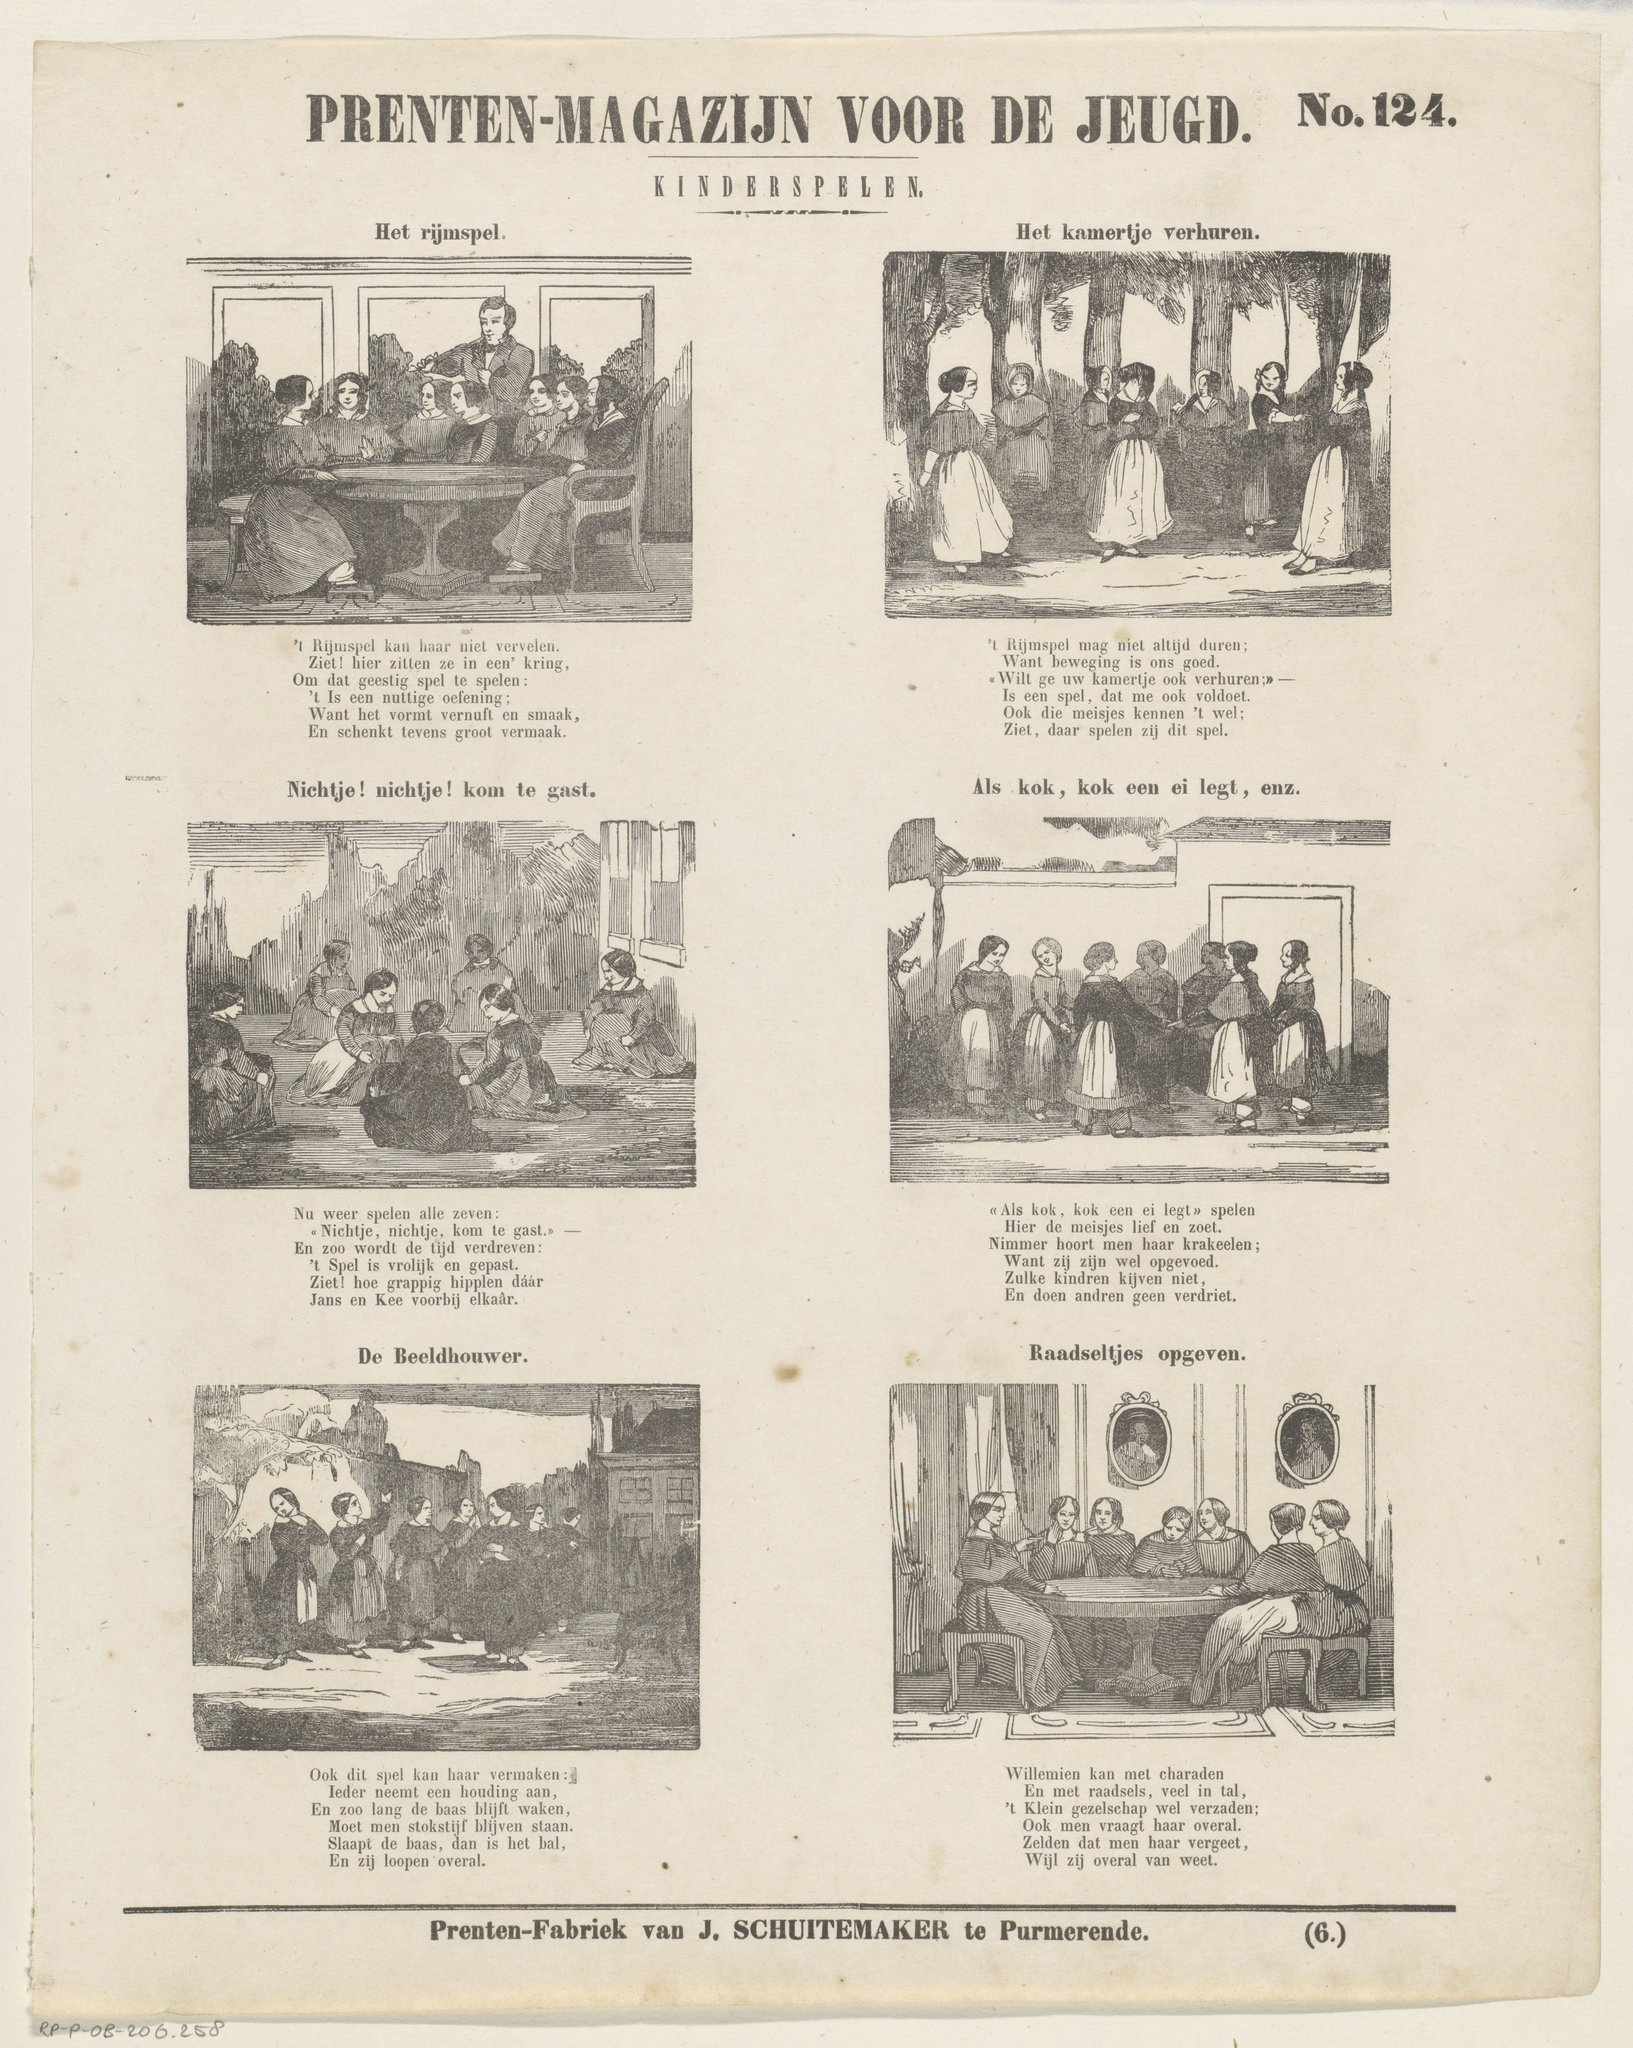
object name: print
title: Prenten-magazijn voor de jeugd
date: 1850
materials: paper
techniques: letterpress printing, engraving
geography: netherlands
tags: children's games and plays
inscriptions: collector's mark: Lugt 2760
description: Na voltooiing van de acht jaargangen van de reeks 'Prenten-magazijn voor de jeugd' in 1850 heeft Jan Schuitemaker al deze prenten heruitgegeven en omgenummerd als nr. 1 t/m 192. De oorspronkelijke jaargang wordt telkens nog vermeld rechtsonder op de prent. Binnen de jaargangen zijn prenten van hetzelfde thema in clusters van vier achter elkaar gezet.